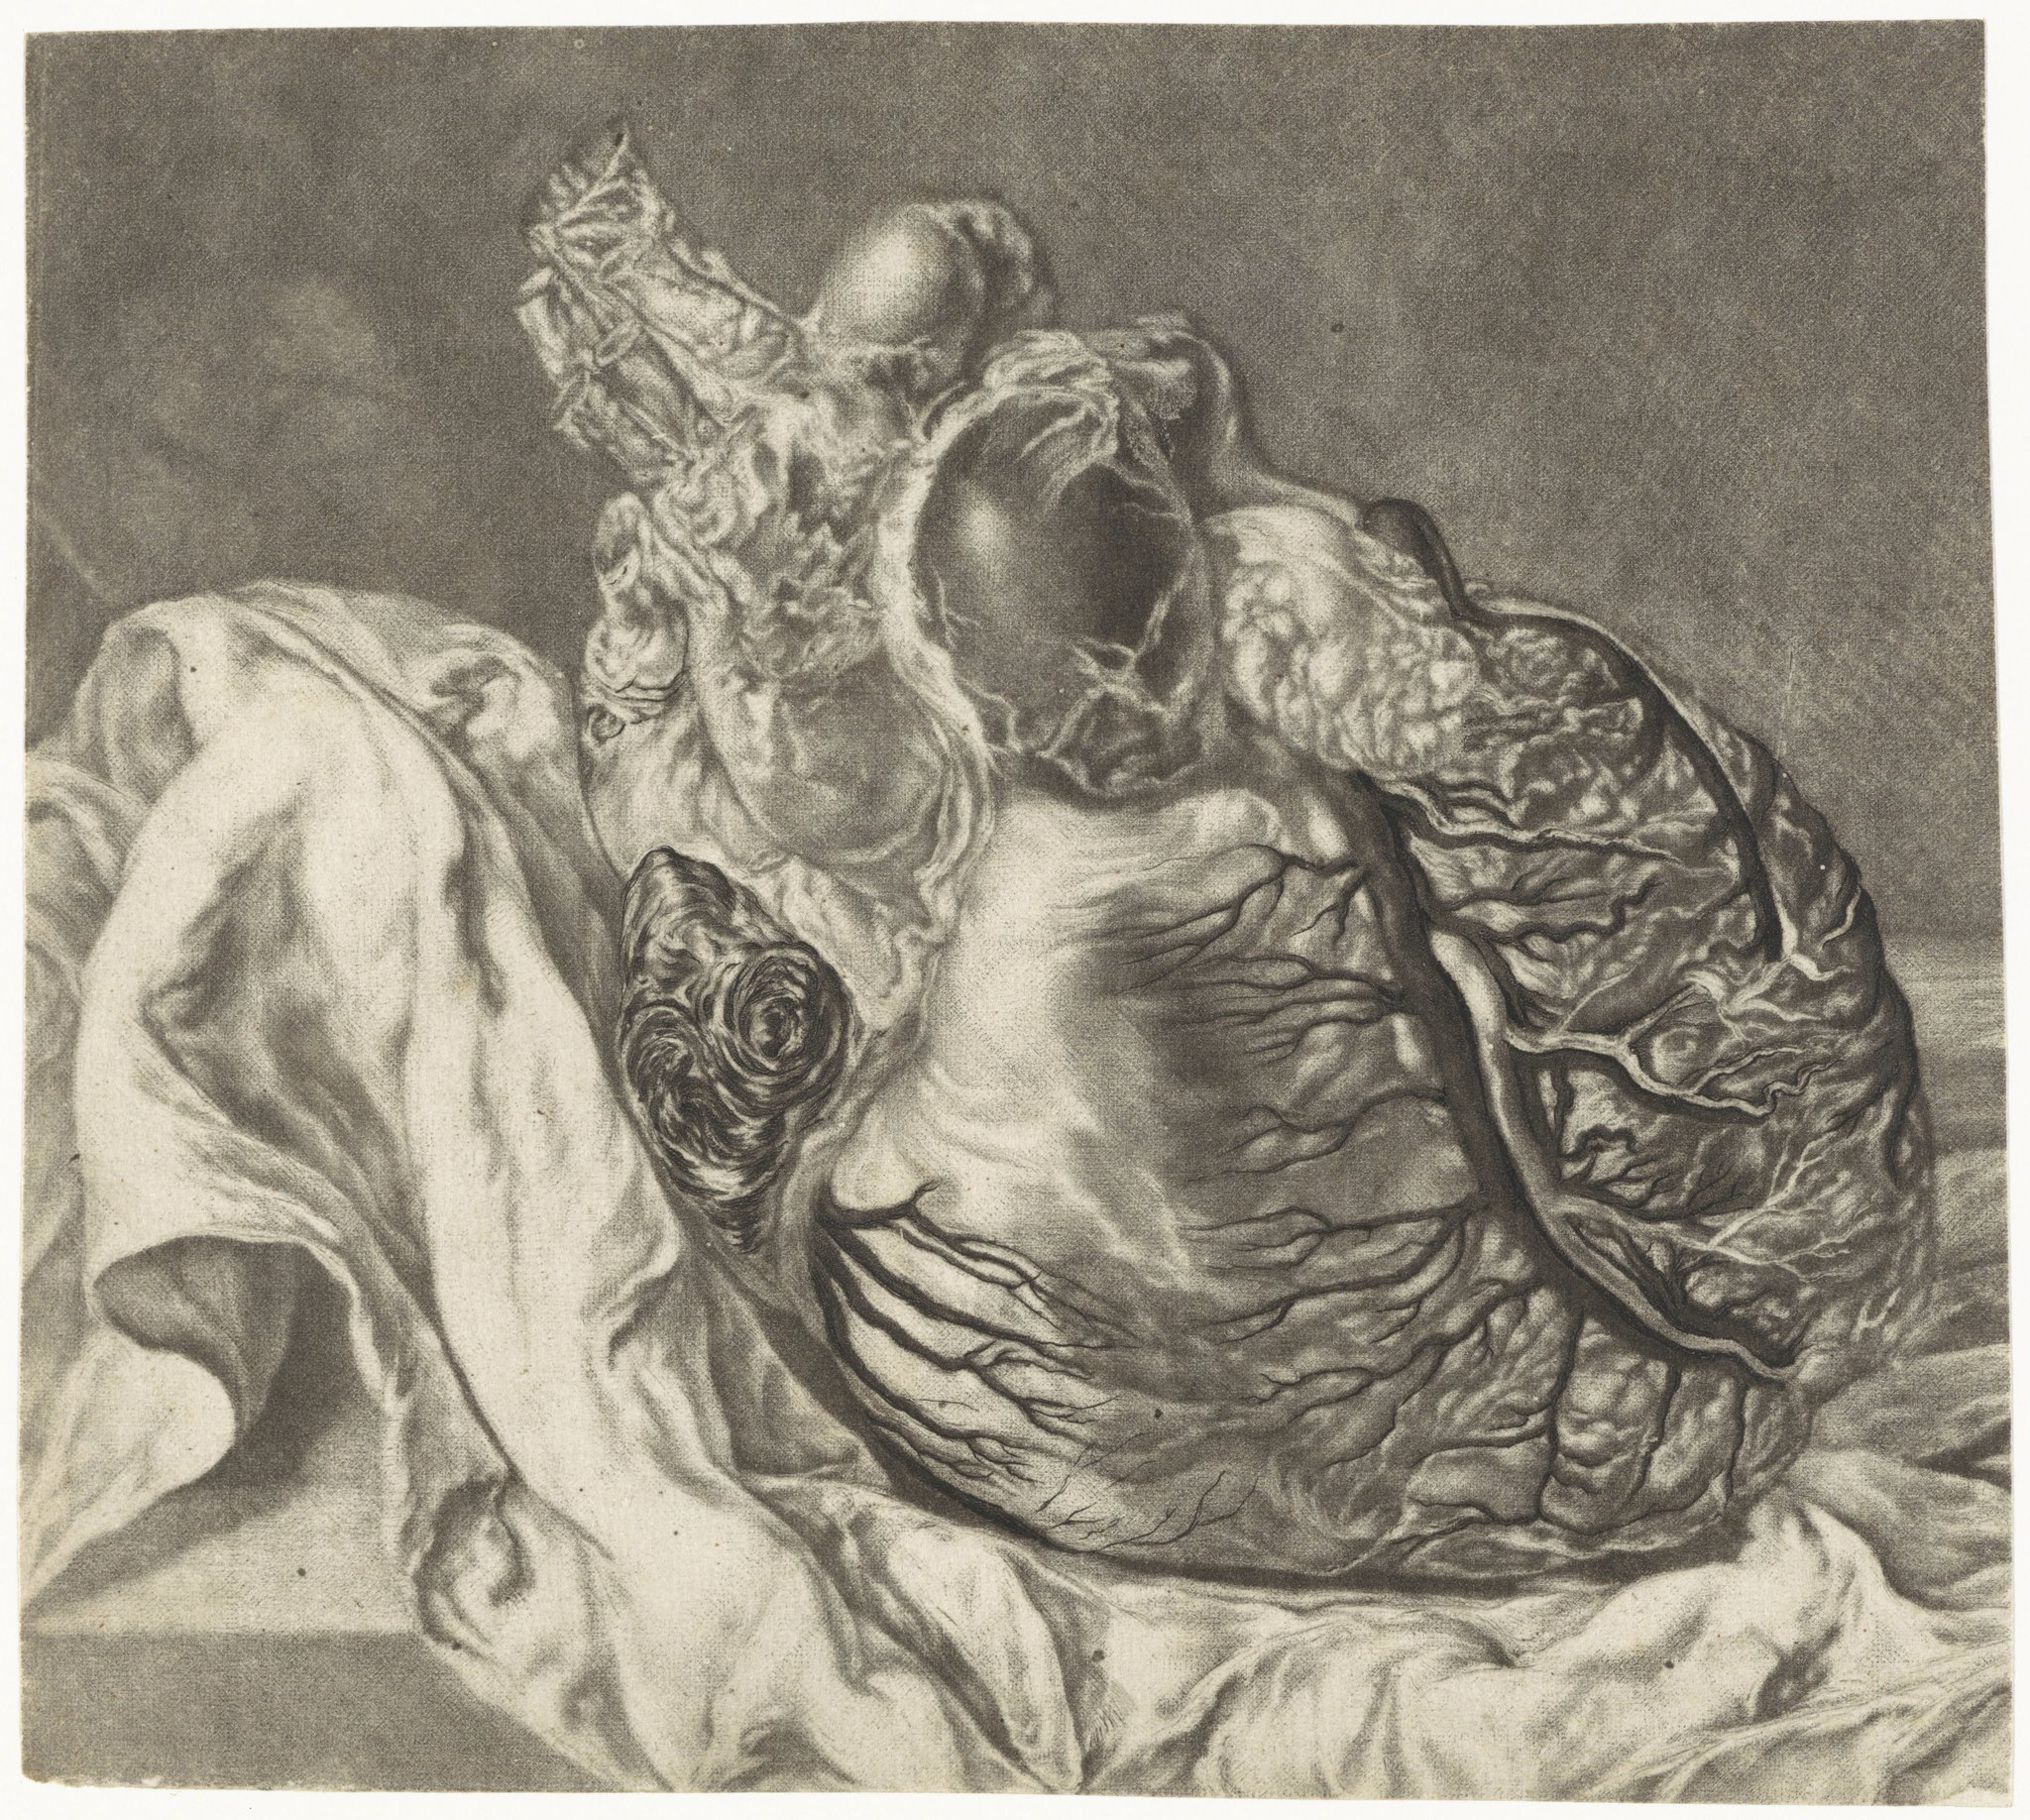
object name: print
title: Prints of the Brain and the Heart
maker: jan l admiral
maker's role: draughtsman, print maker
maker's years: 1699-1773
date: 1700-1750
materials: paper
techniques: etching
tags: heart, other anatomical details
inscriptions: collector's mark: Lugt 2228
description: Around 1735 Jan l’Admiral printed several remarkable anatomical prints in colour, among others on commission for the celebrated physician Frederik Ruysch. For his illustrations of the cerebral membrane (the skull of an unborn child) and a human heart he experimented with ever different colours, and made various versions of them. The objective was to provide medical practitioners with the most precise and realistic images possible.